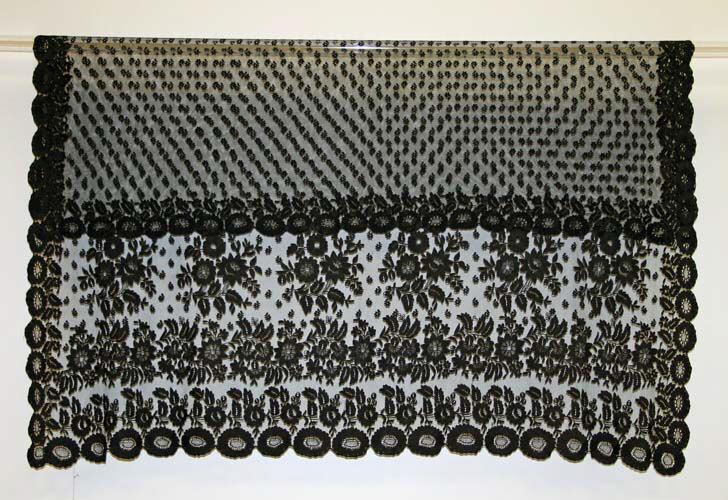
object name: veil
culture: american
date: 1840-1849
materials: cotton